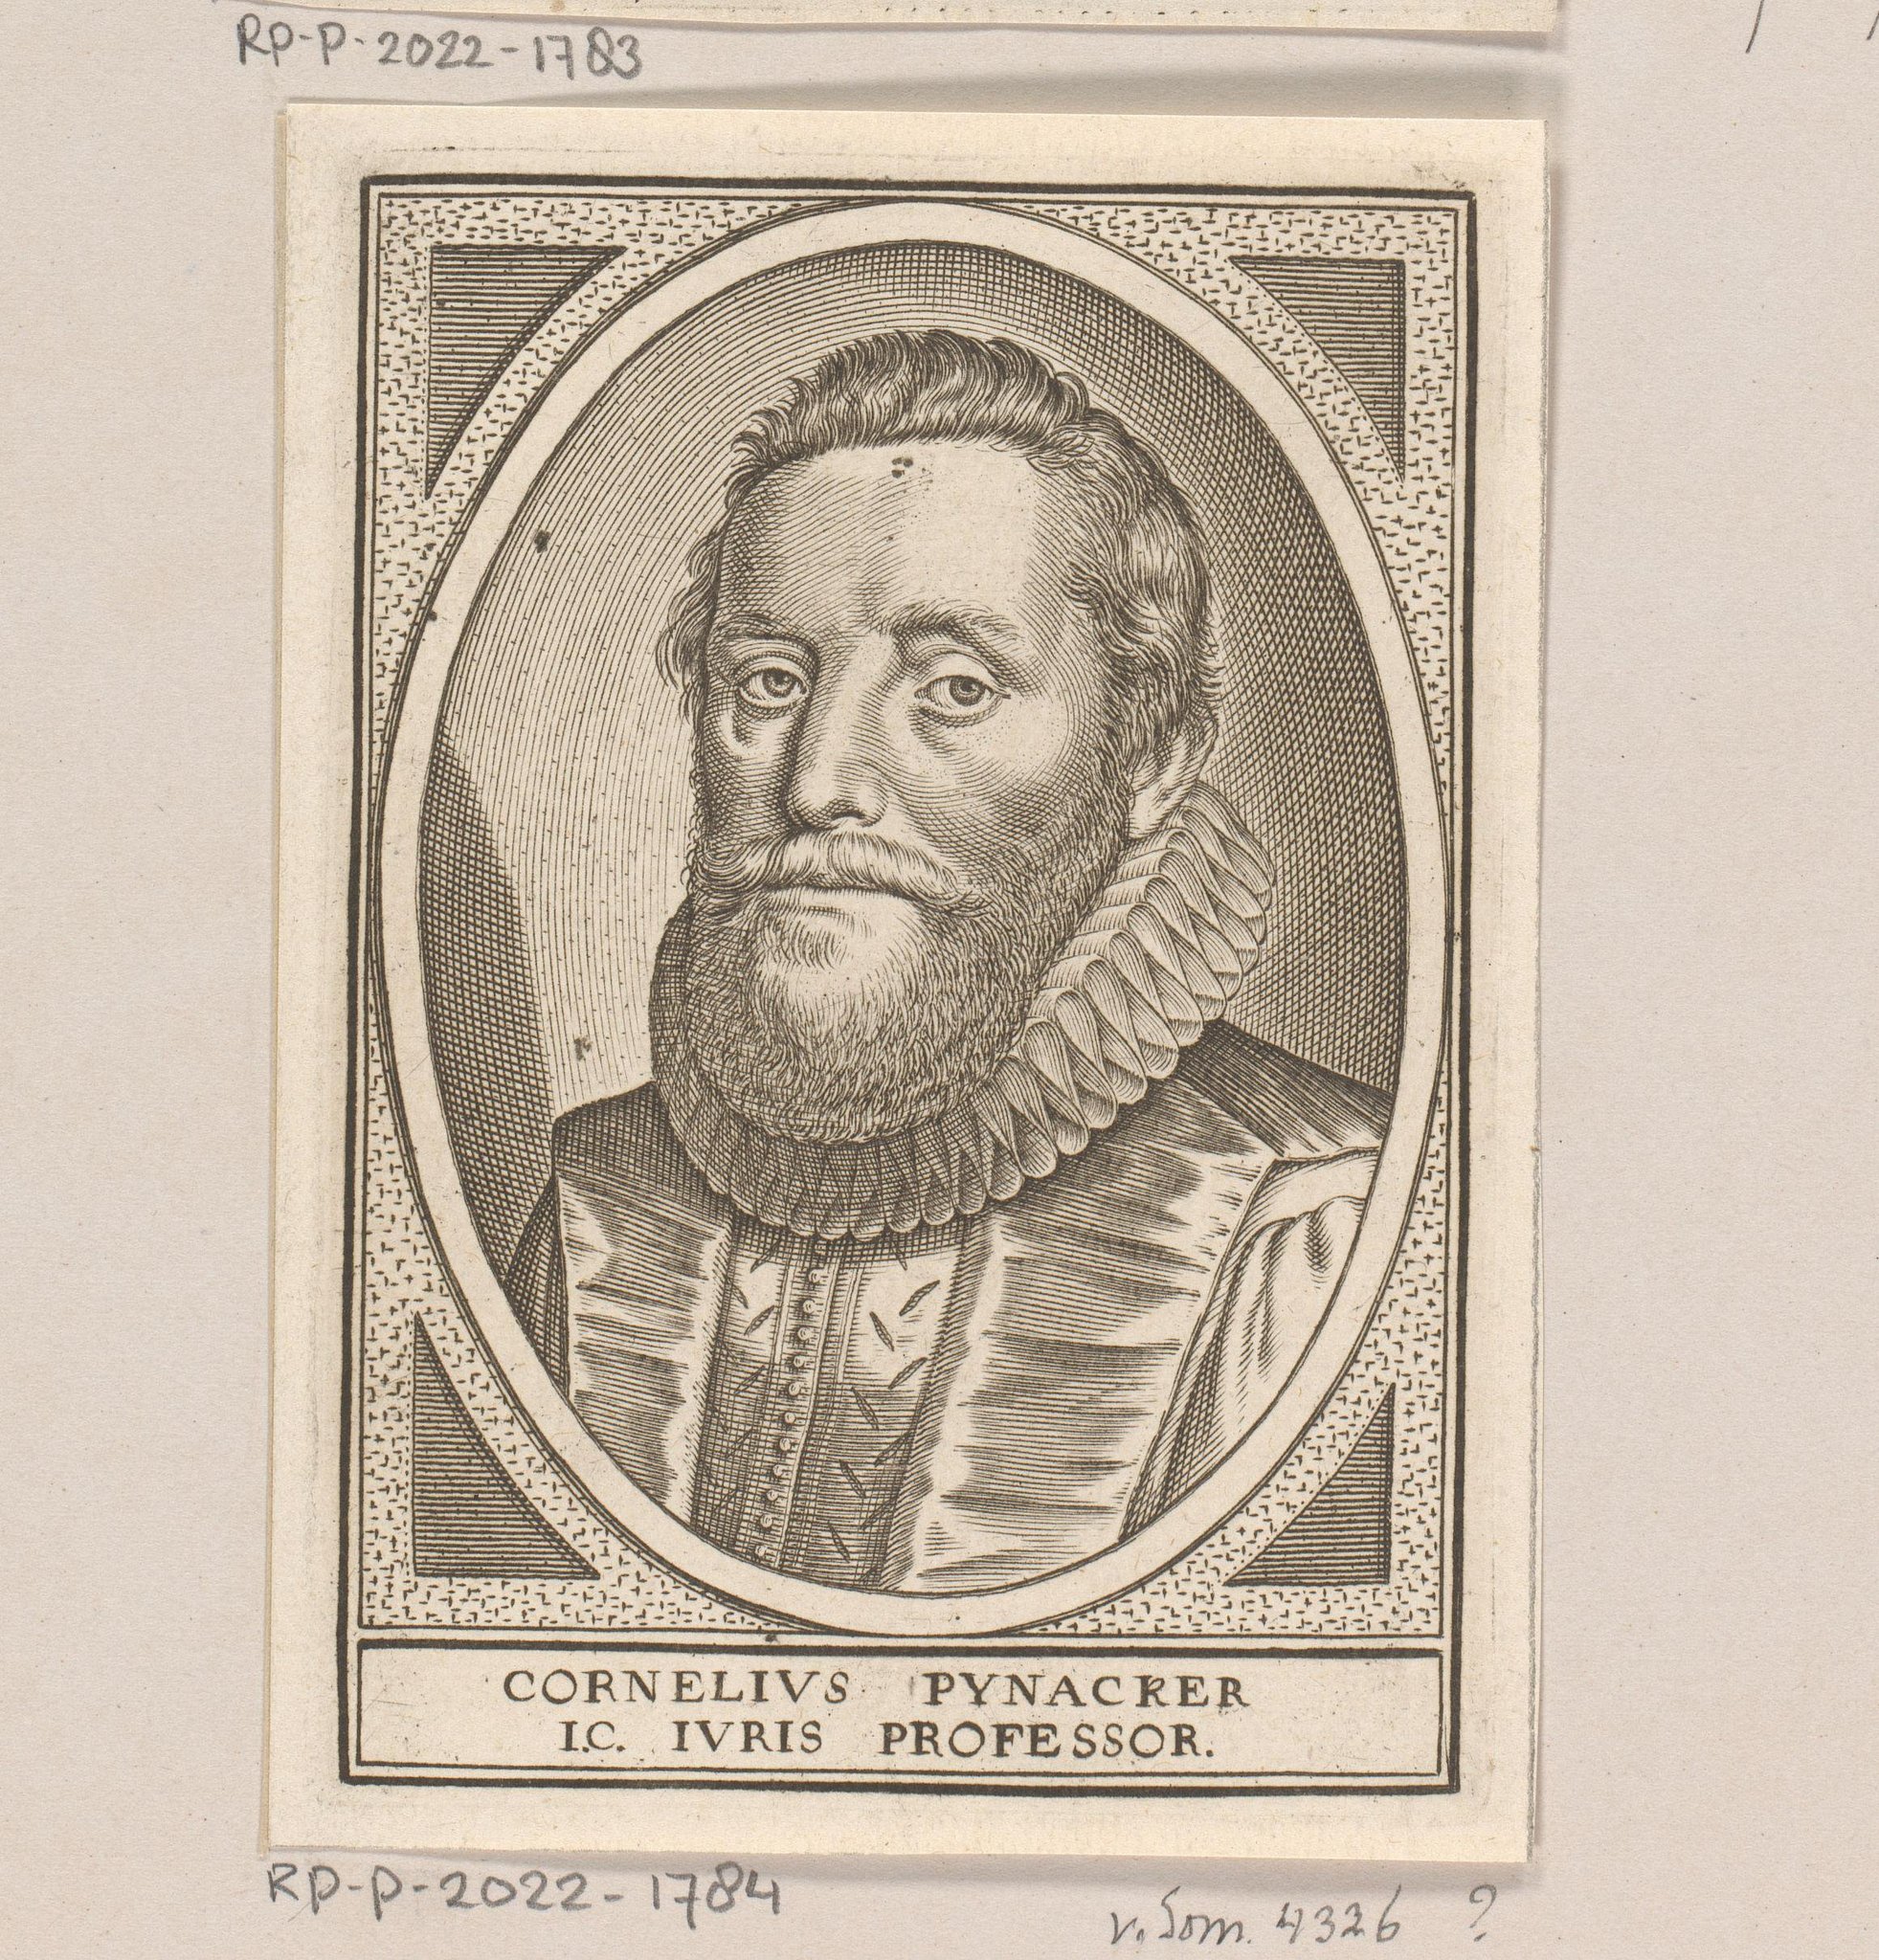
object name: print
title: Portret van Cornelis Pijnacker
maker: Anonymous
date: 1600-1699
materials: paper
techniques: engraving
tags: cornelis pijnacker, historical persons, professor, map making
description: Met tweeregelig onderschrift in het Latijn.